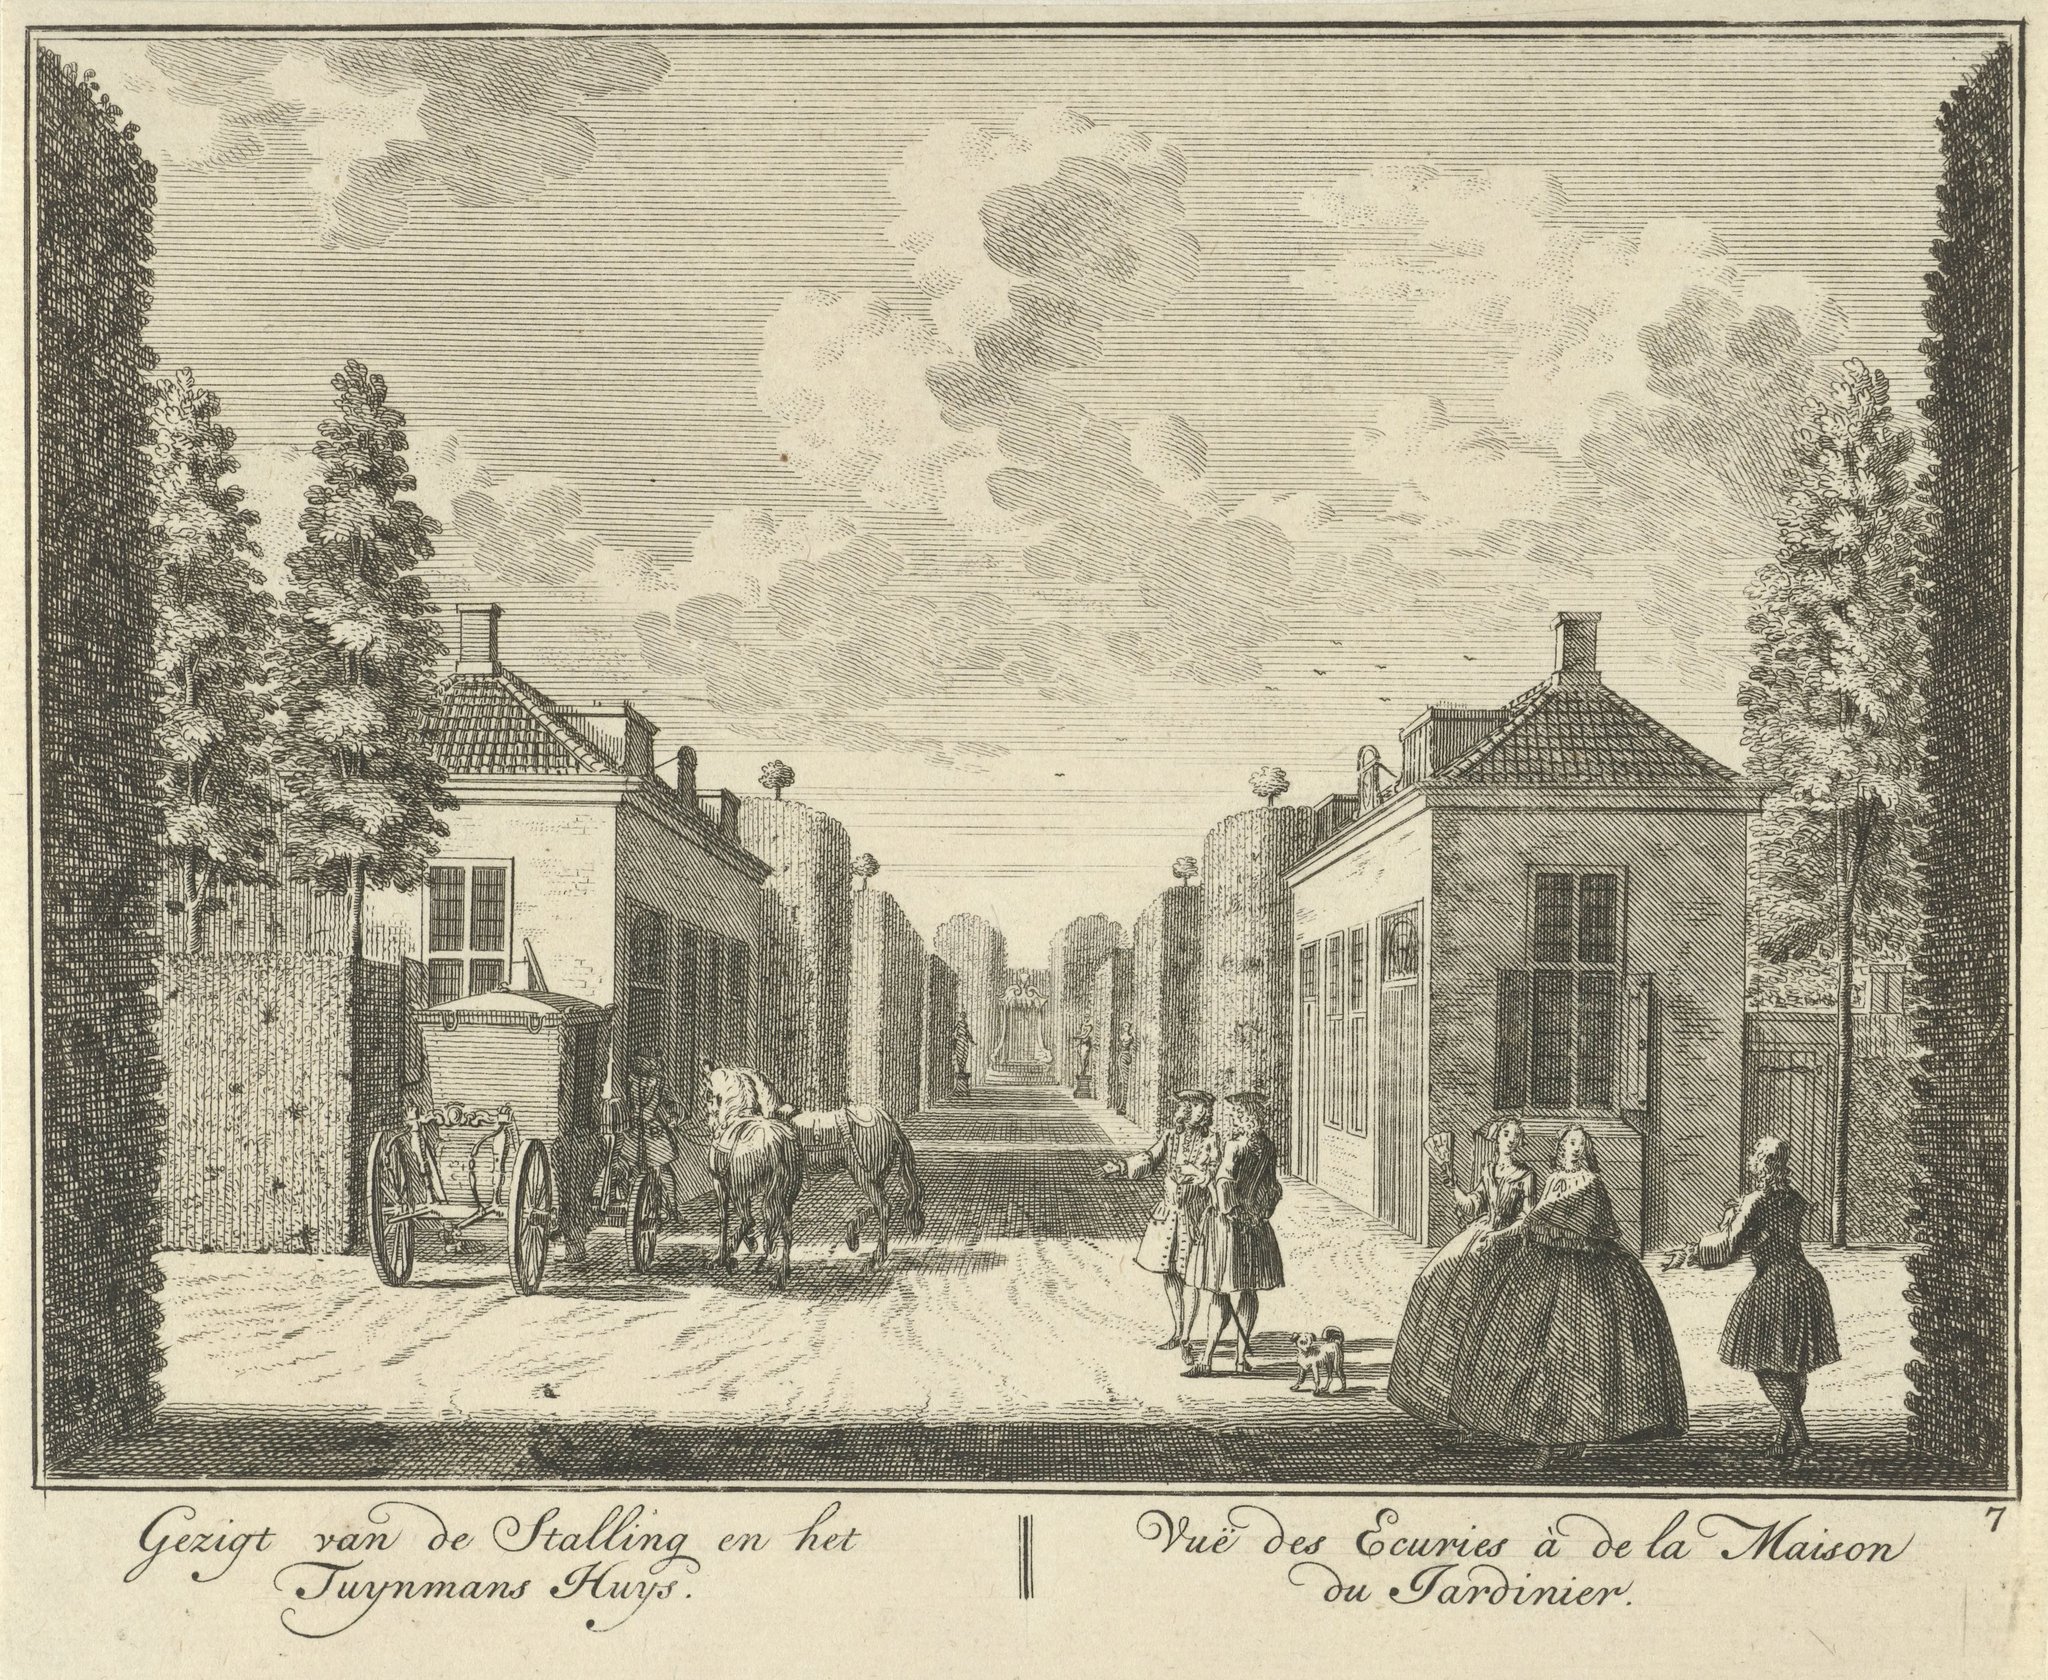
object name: print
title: Stallen op het landgoed van Huis ter Meer te Maarssen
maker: hendrik de leth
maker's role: draughtsman, print maker, publisher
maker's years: 1703-1766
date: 1740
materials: paper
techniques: etching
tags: stall, stable, country-house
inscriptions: collector's mark: Lugt 2228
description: Gezicht op de stallen en het huis van de tuinman op het landgoed van Huis ter Meer. De prent maakt deel uit van een serie met 26 gezichten op Huis ter Meer en het bijbehorende landgoed te Maarssen.